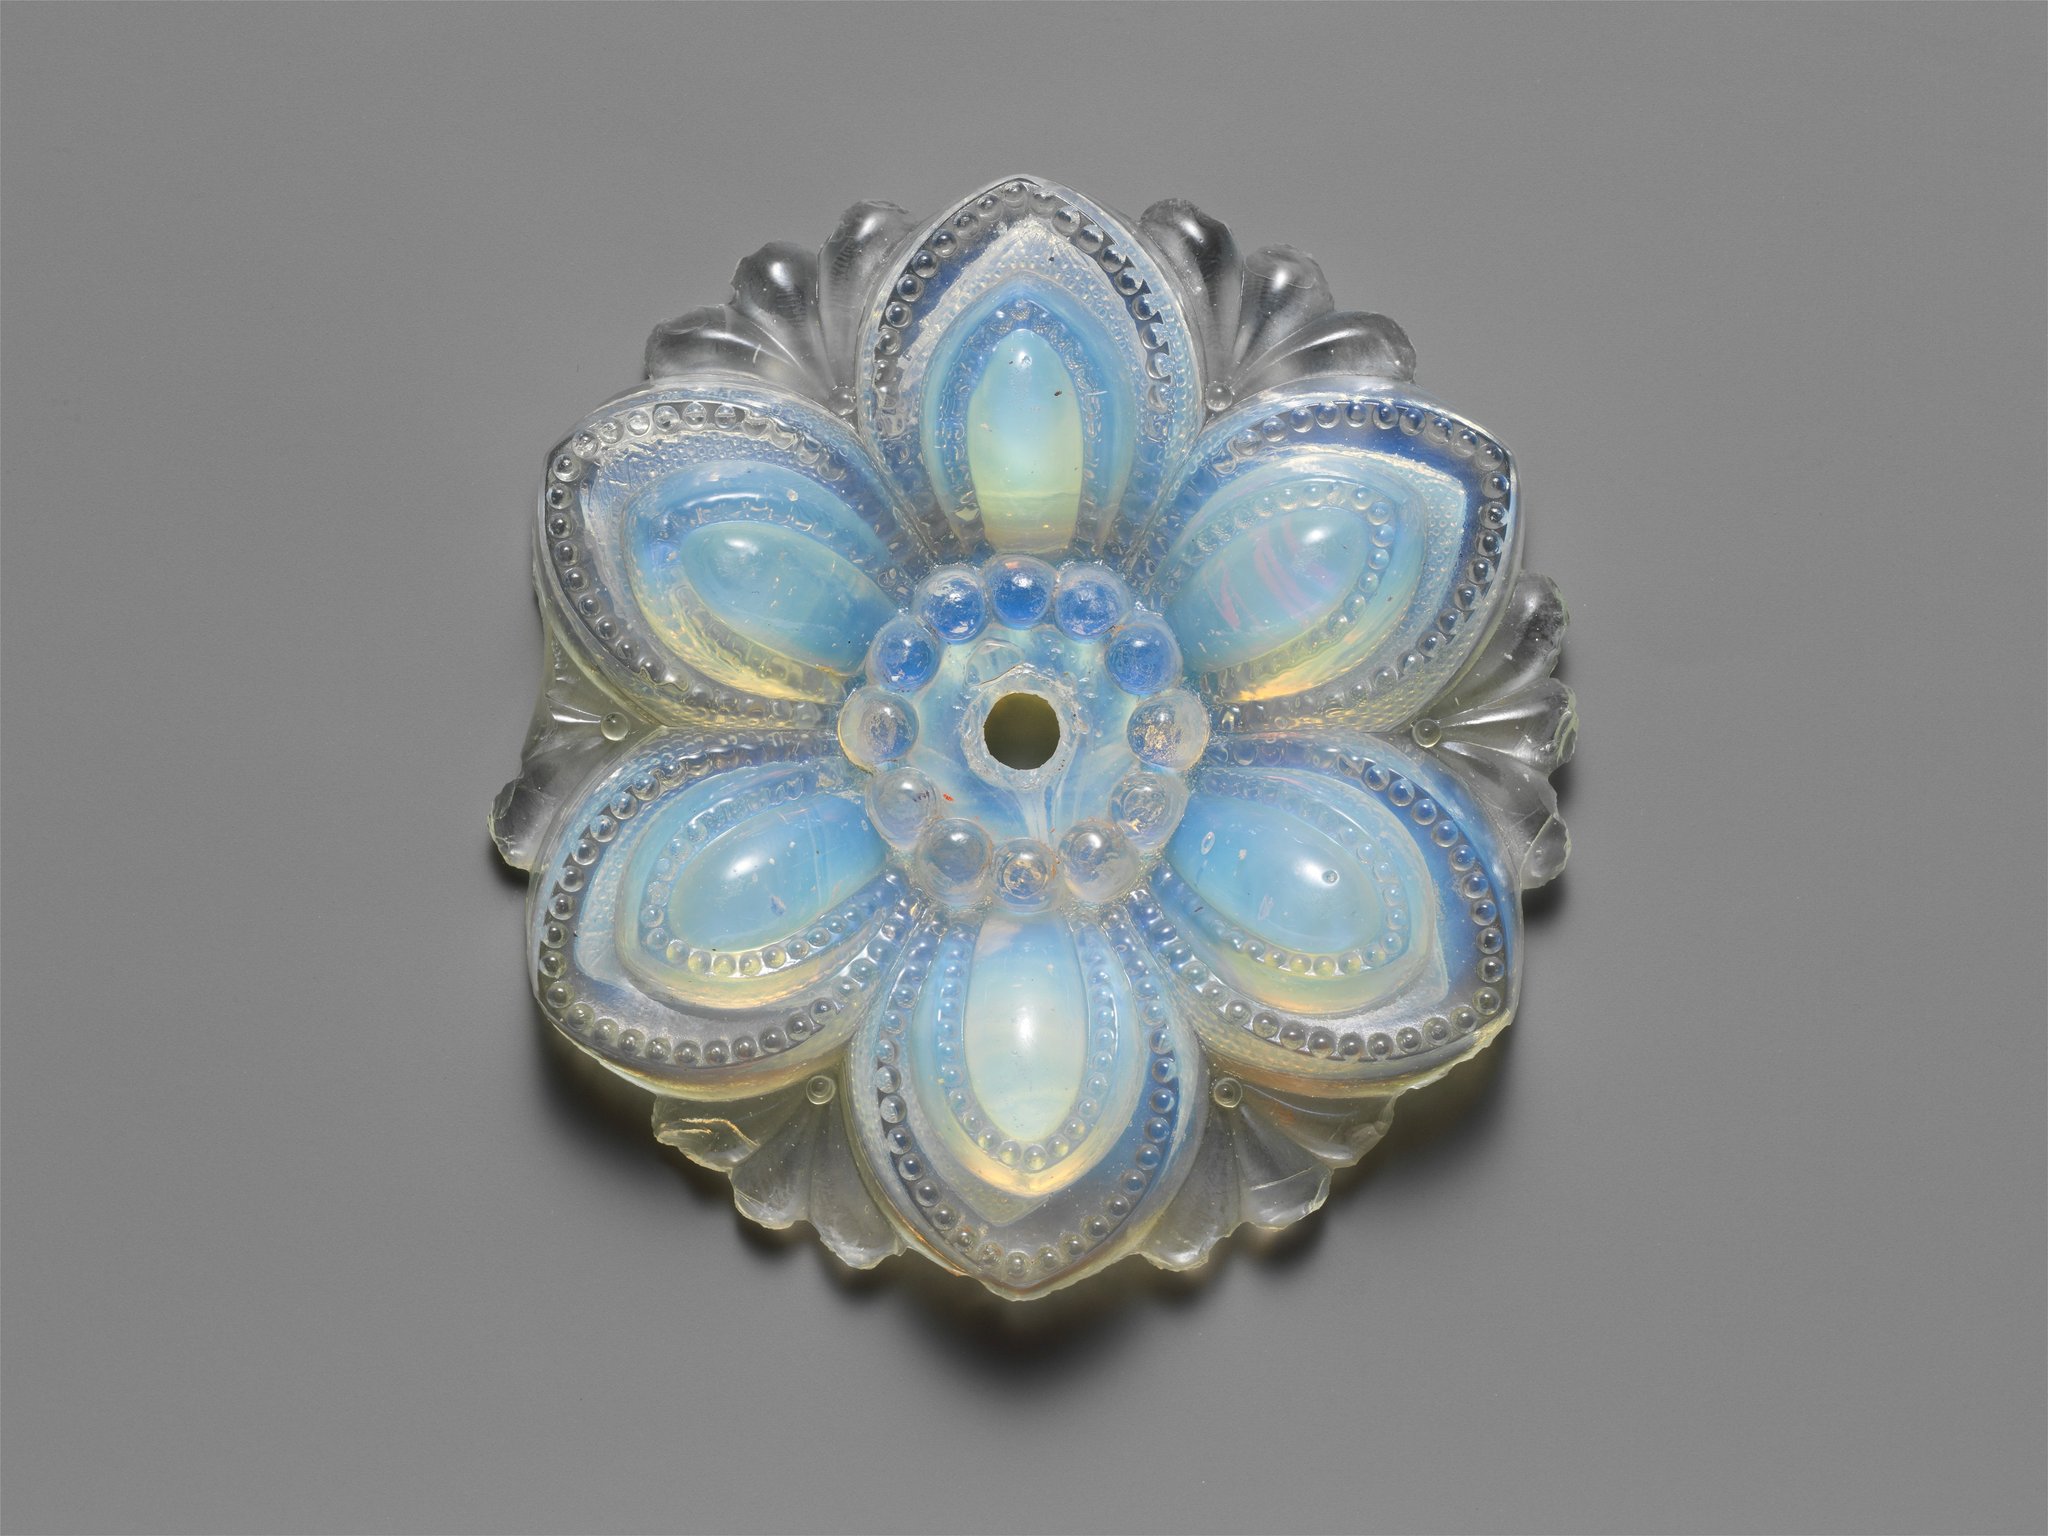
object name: curtain knob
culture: american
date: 1840-1860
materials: glass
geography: united states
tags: flowers